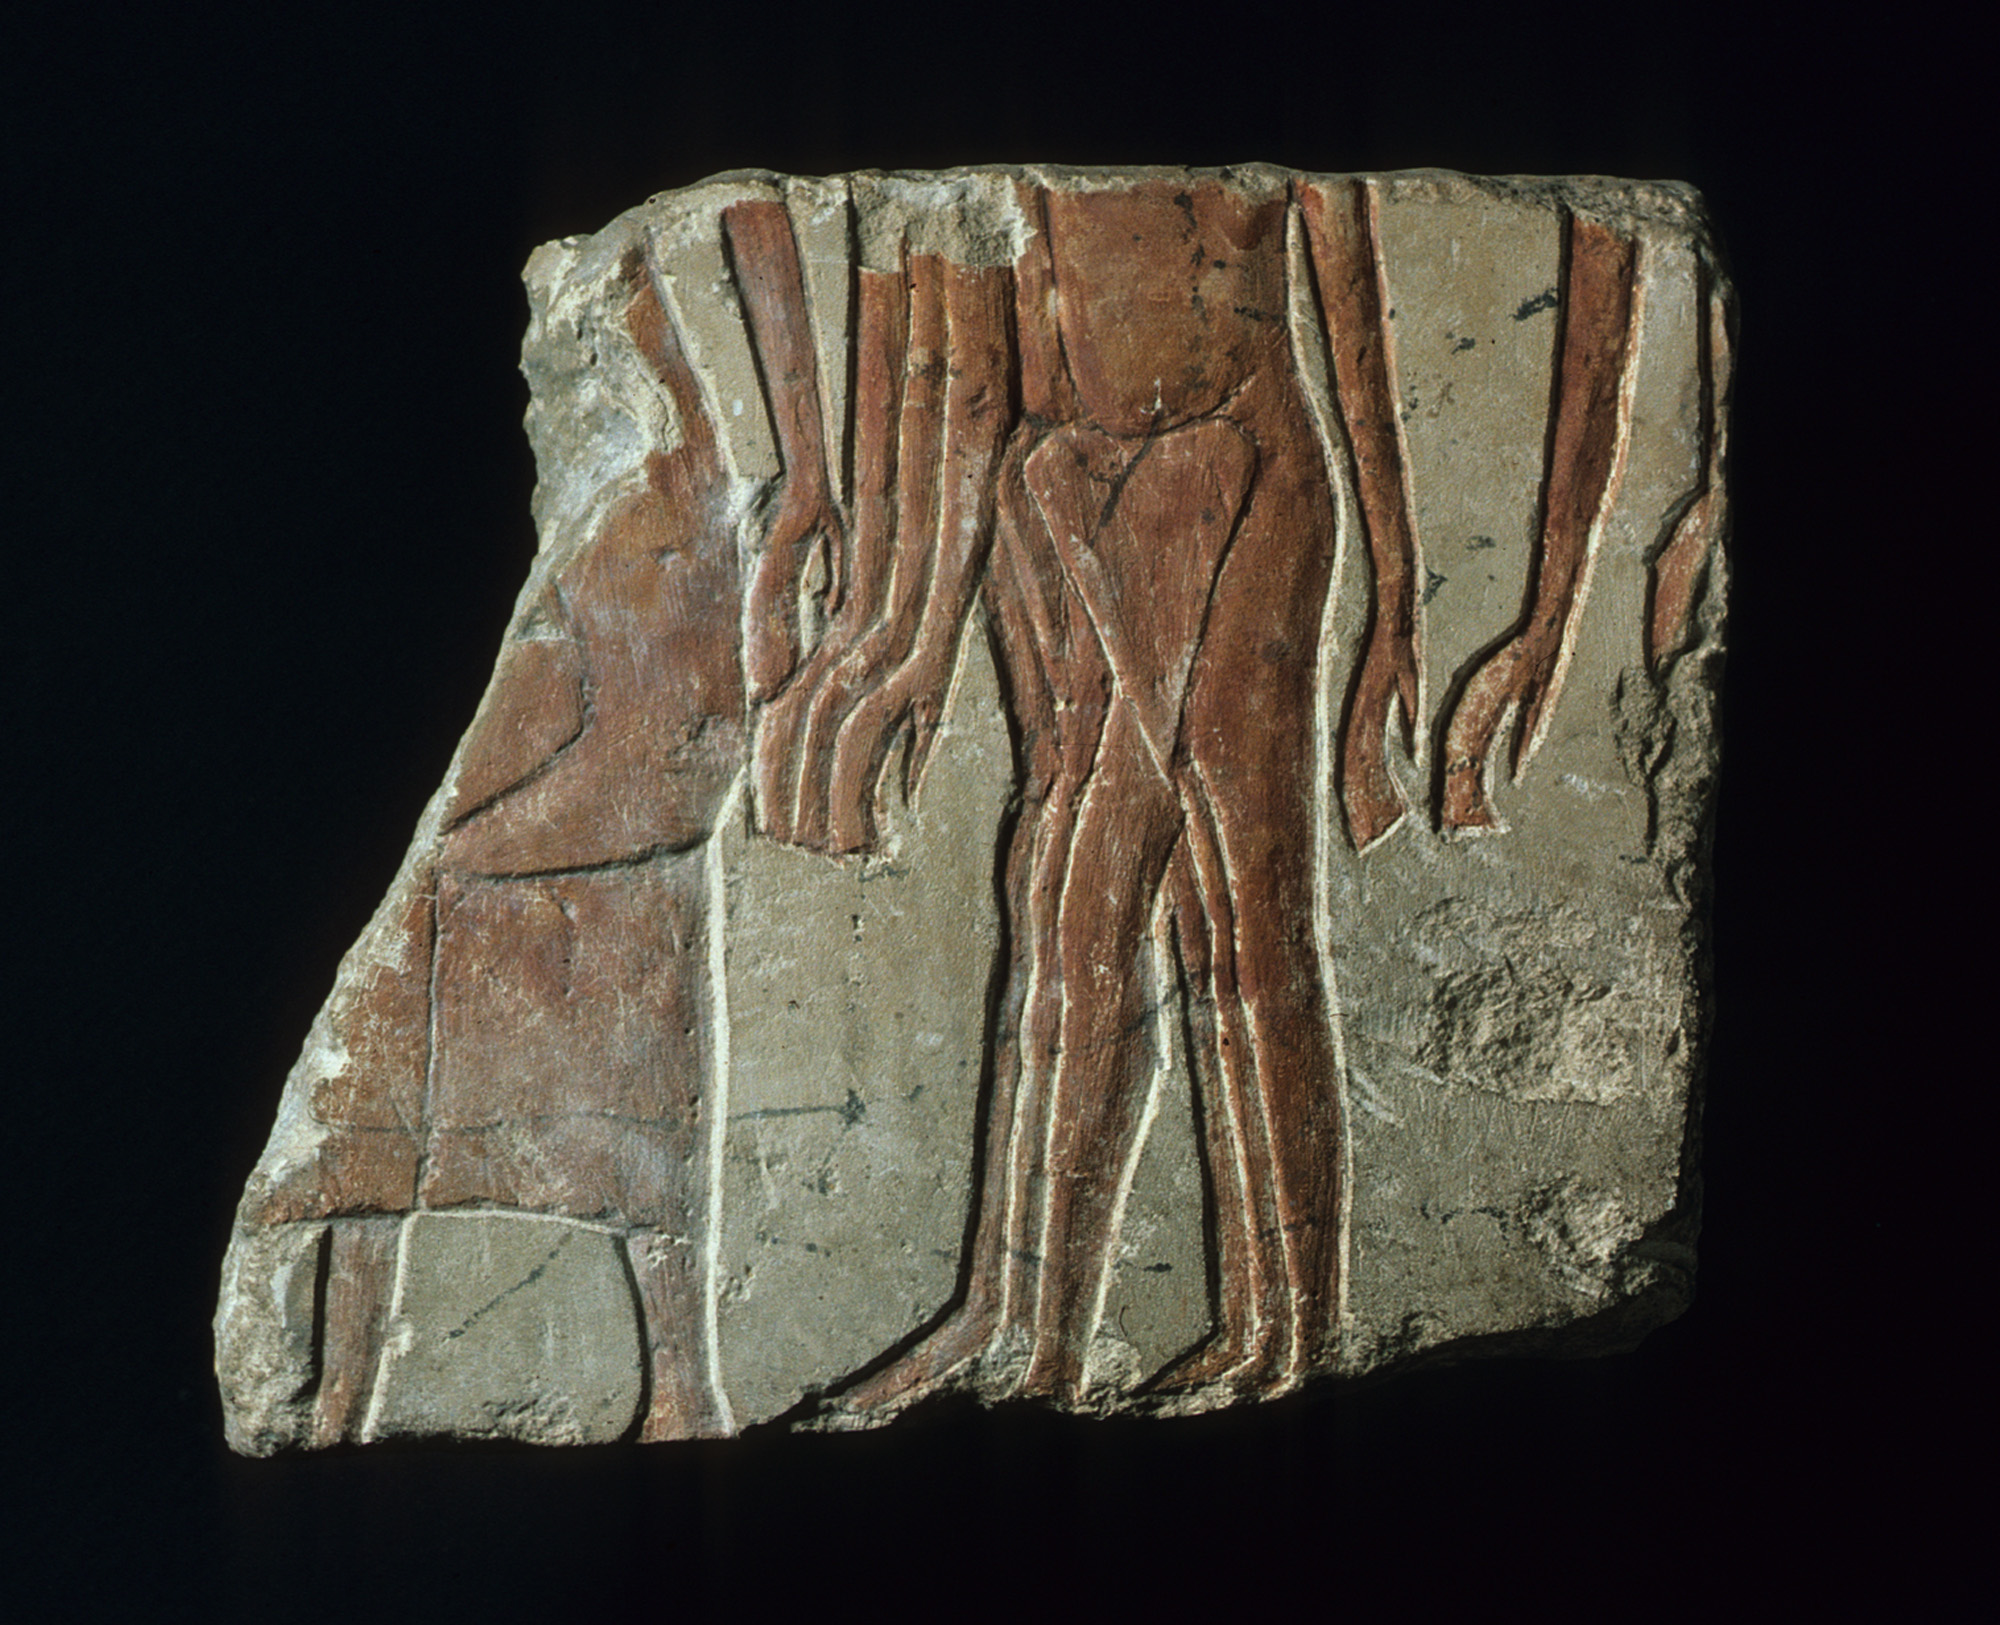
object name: talatat, men following official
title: Relief with men following an official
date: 1353-1336 BCE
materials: limestone, paint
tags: men